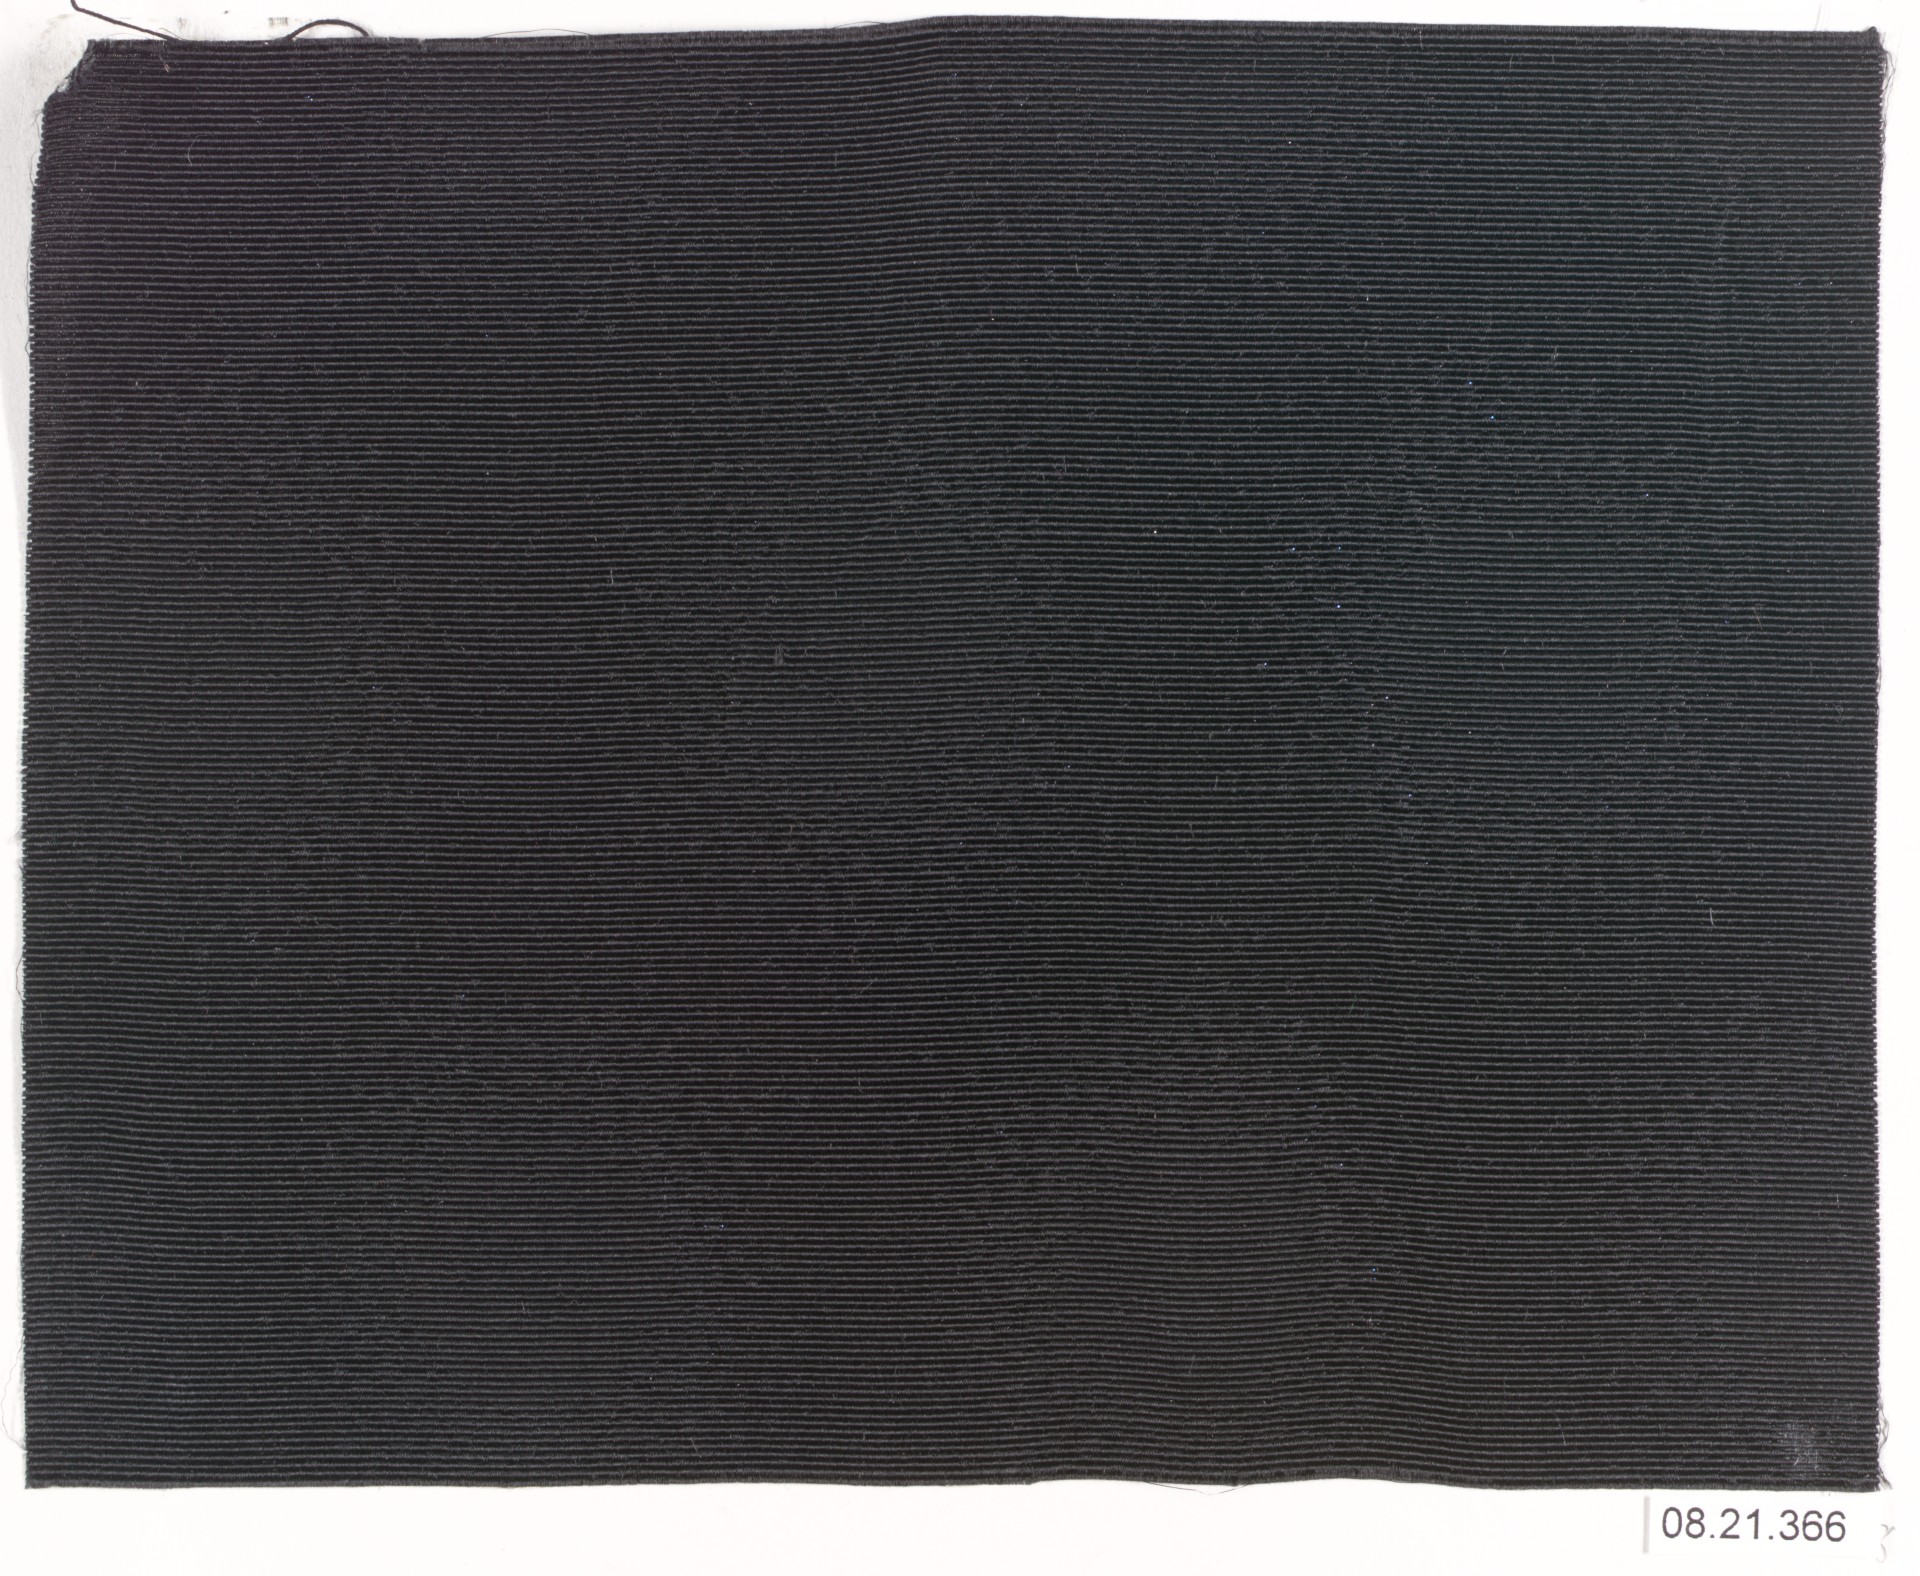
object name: textile sample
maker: Anonymous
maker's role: designer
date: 1900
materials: silk